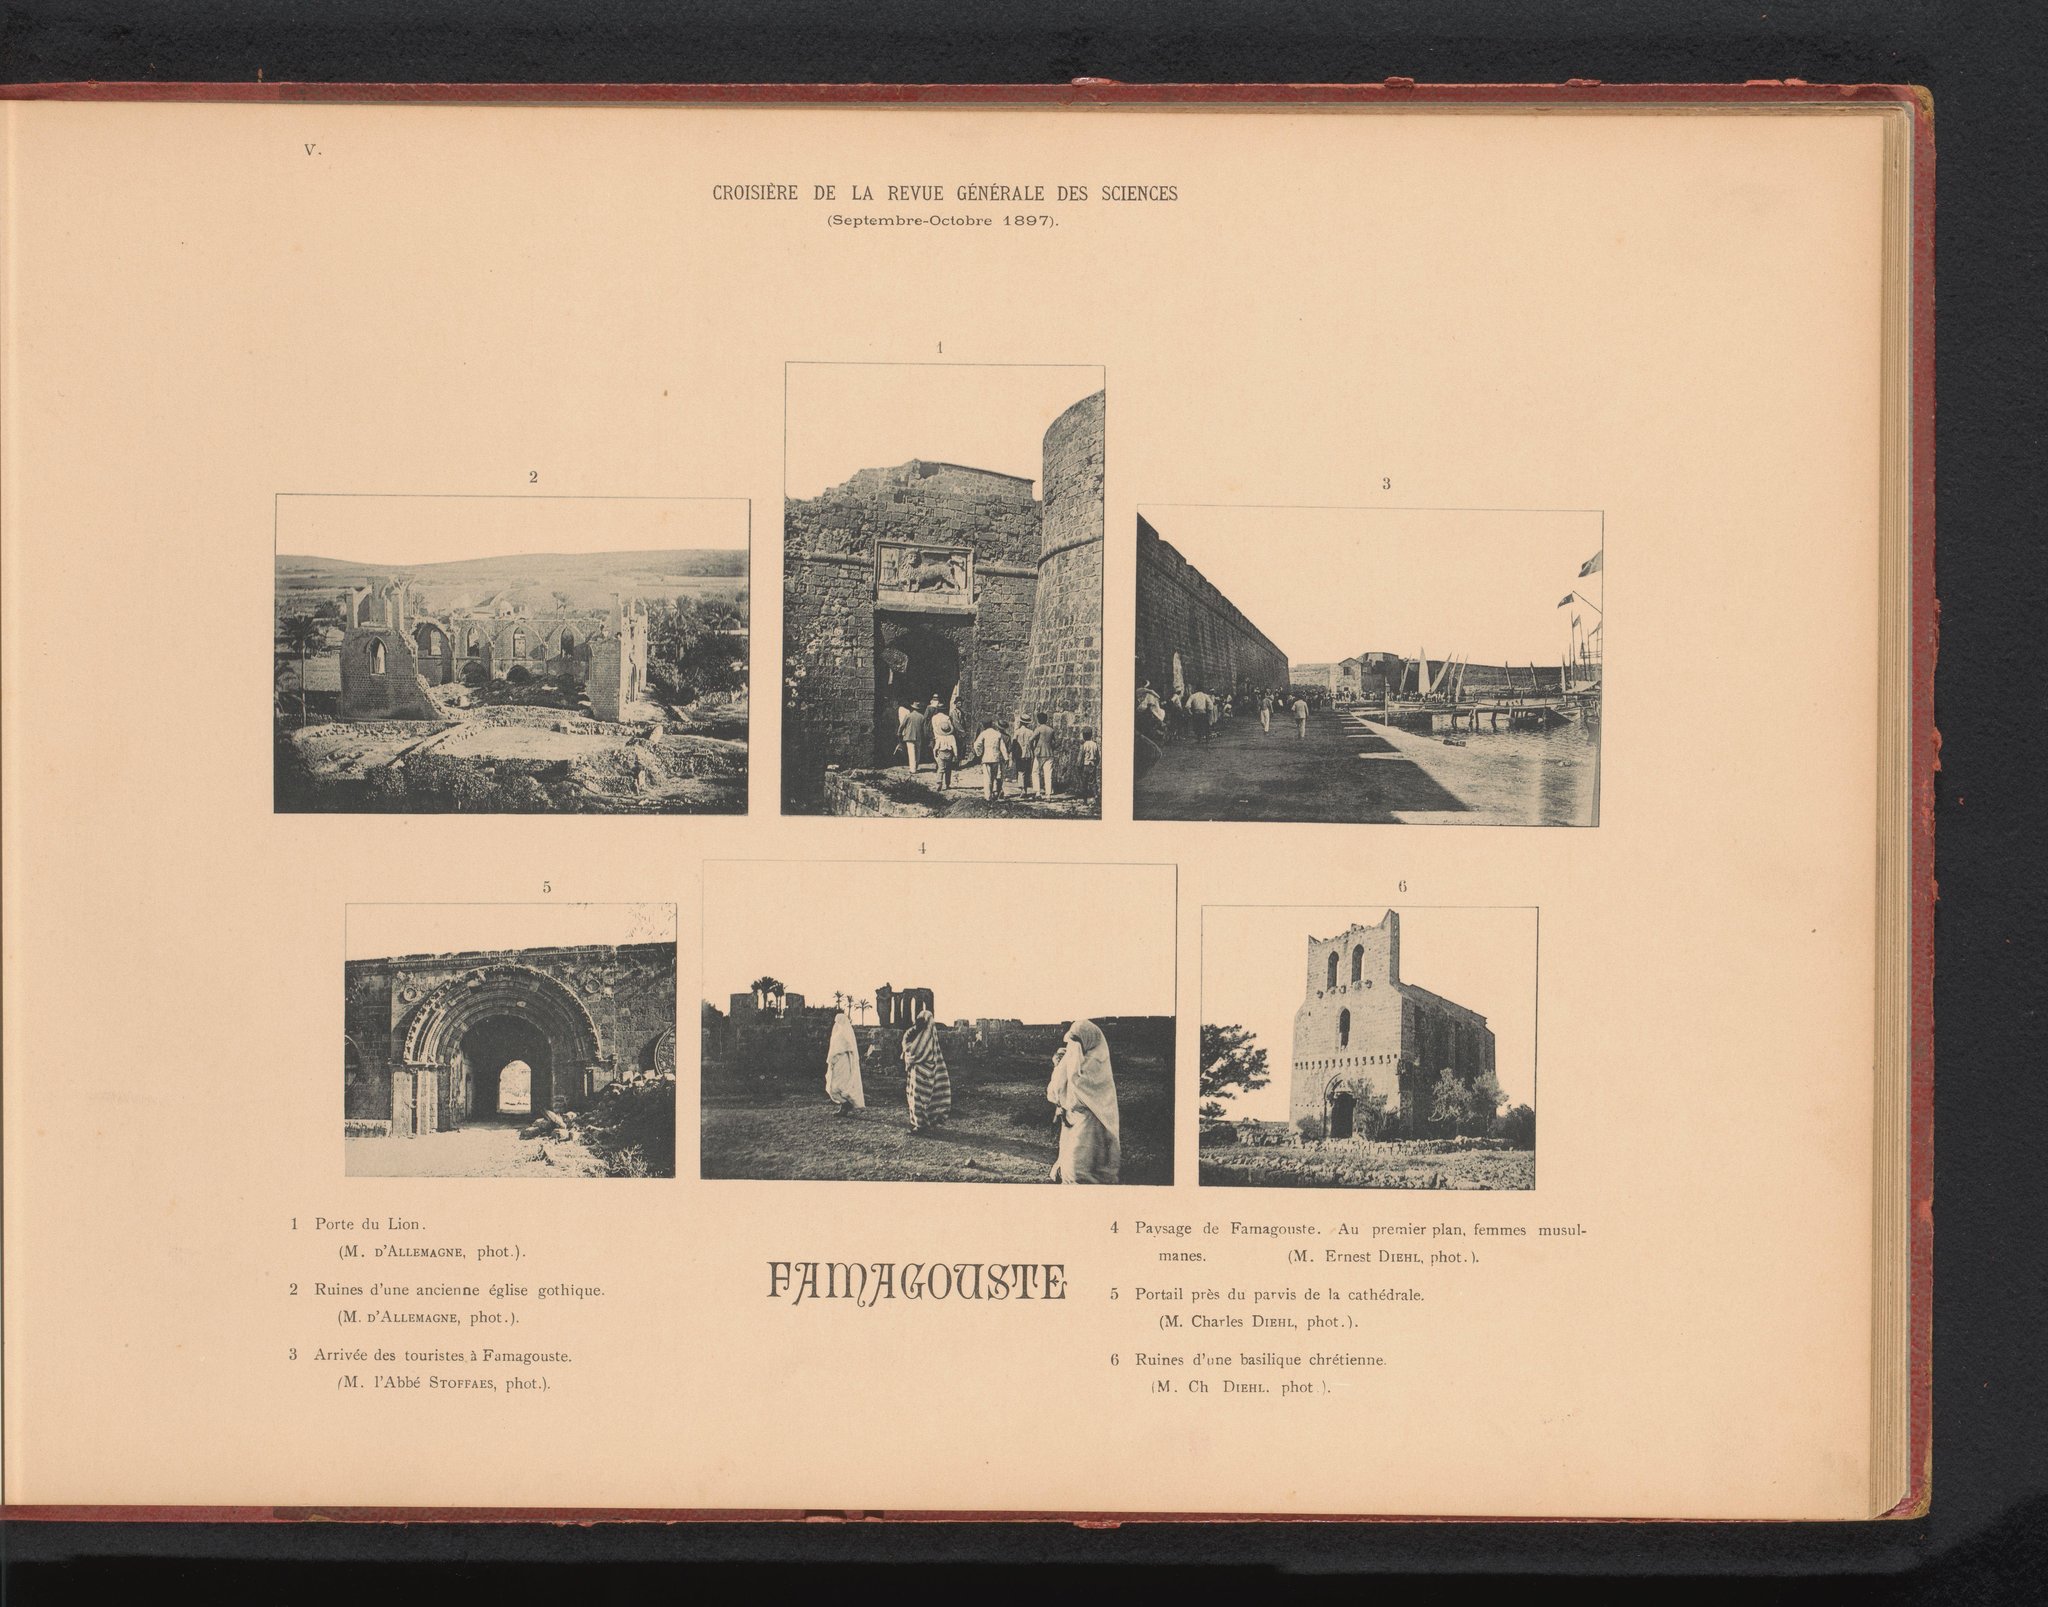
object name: page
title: Adalia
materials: paper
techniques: photograph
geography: paris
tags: prospect of village, silhouette of village, adult woman, child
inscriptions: inscription: ‘1 Murailles de la ville haute./ (M. Charles Diehl, phot.)./ 2 Groupe de femmes et de jeunes filles grecques sur le seuil/ d'une maison grecque. (M. d'Allemagne, phot.)./ 3 Boutiques de marchands./ (M. d'Allemagne, phot.)./ 4 Femmes turques en promenade le long des remparts. A gau-/ che : jeune garçon turc. (M. Charles Diehl, phot.)./ 5 Enfants grecs sortant de l'école./ (M. Ernest Diehl, phot.)./ 6 Femmes et jeunes filles grecques en promenade dans les jardins./ (M. Spanier, phot.)./ 7 Halte de chameaux au marché./ (Mme de Tavernier, phot.).’, number: ‘IV.’